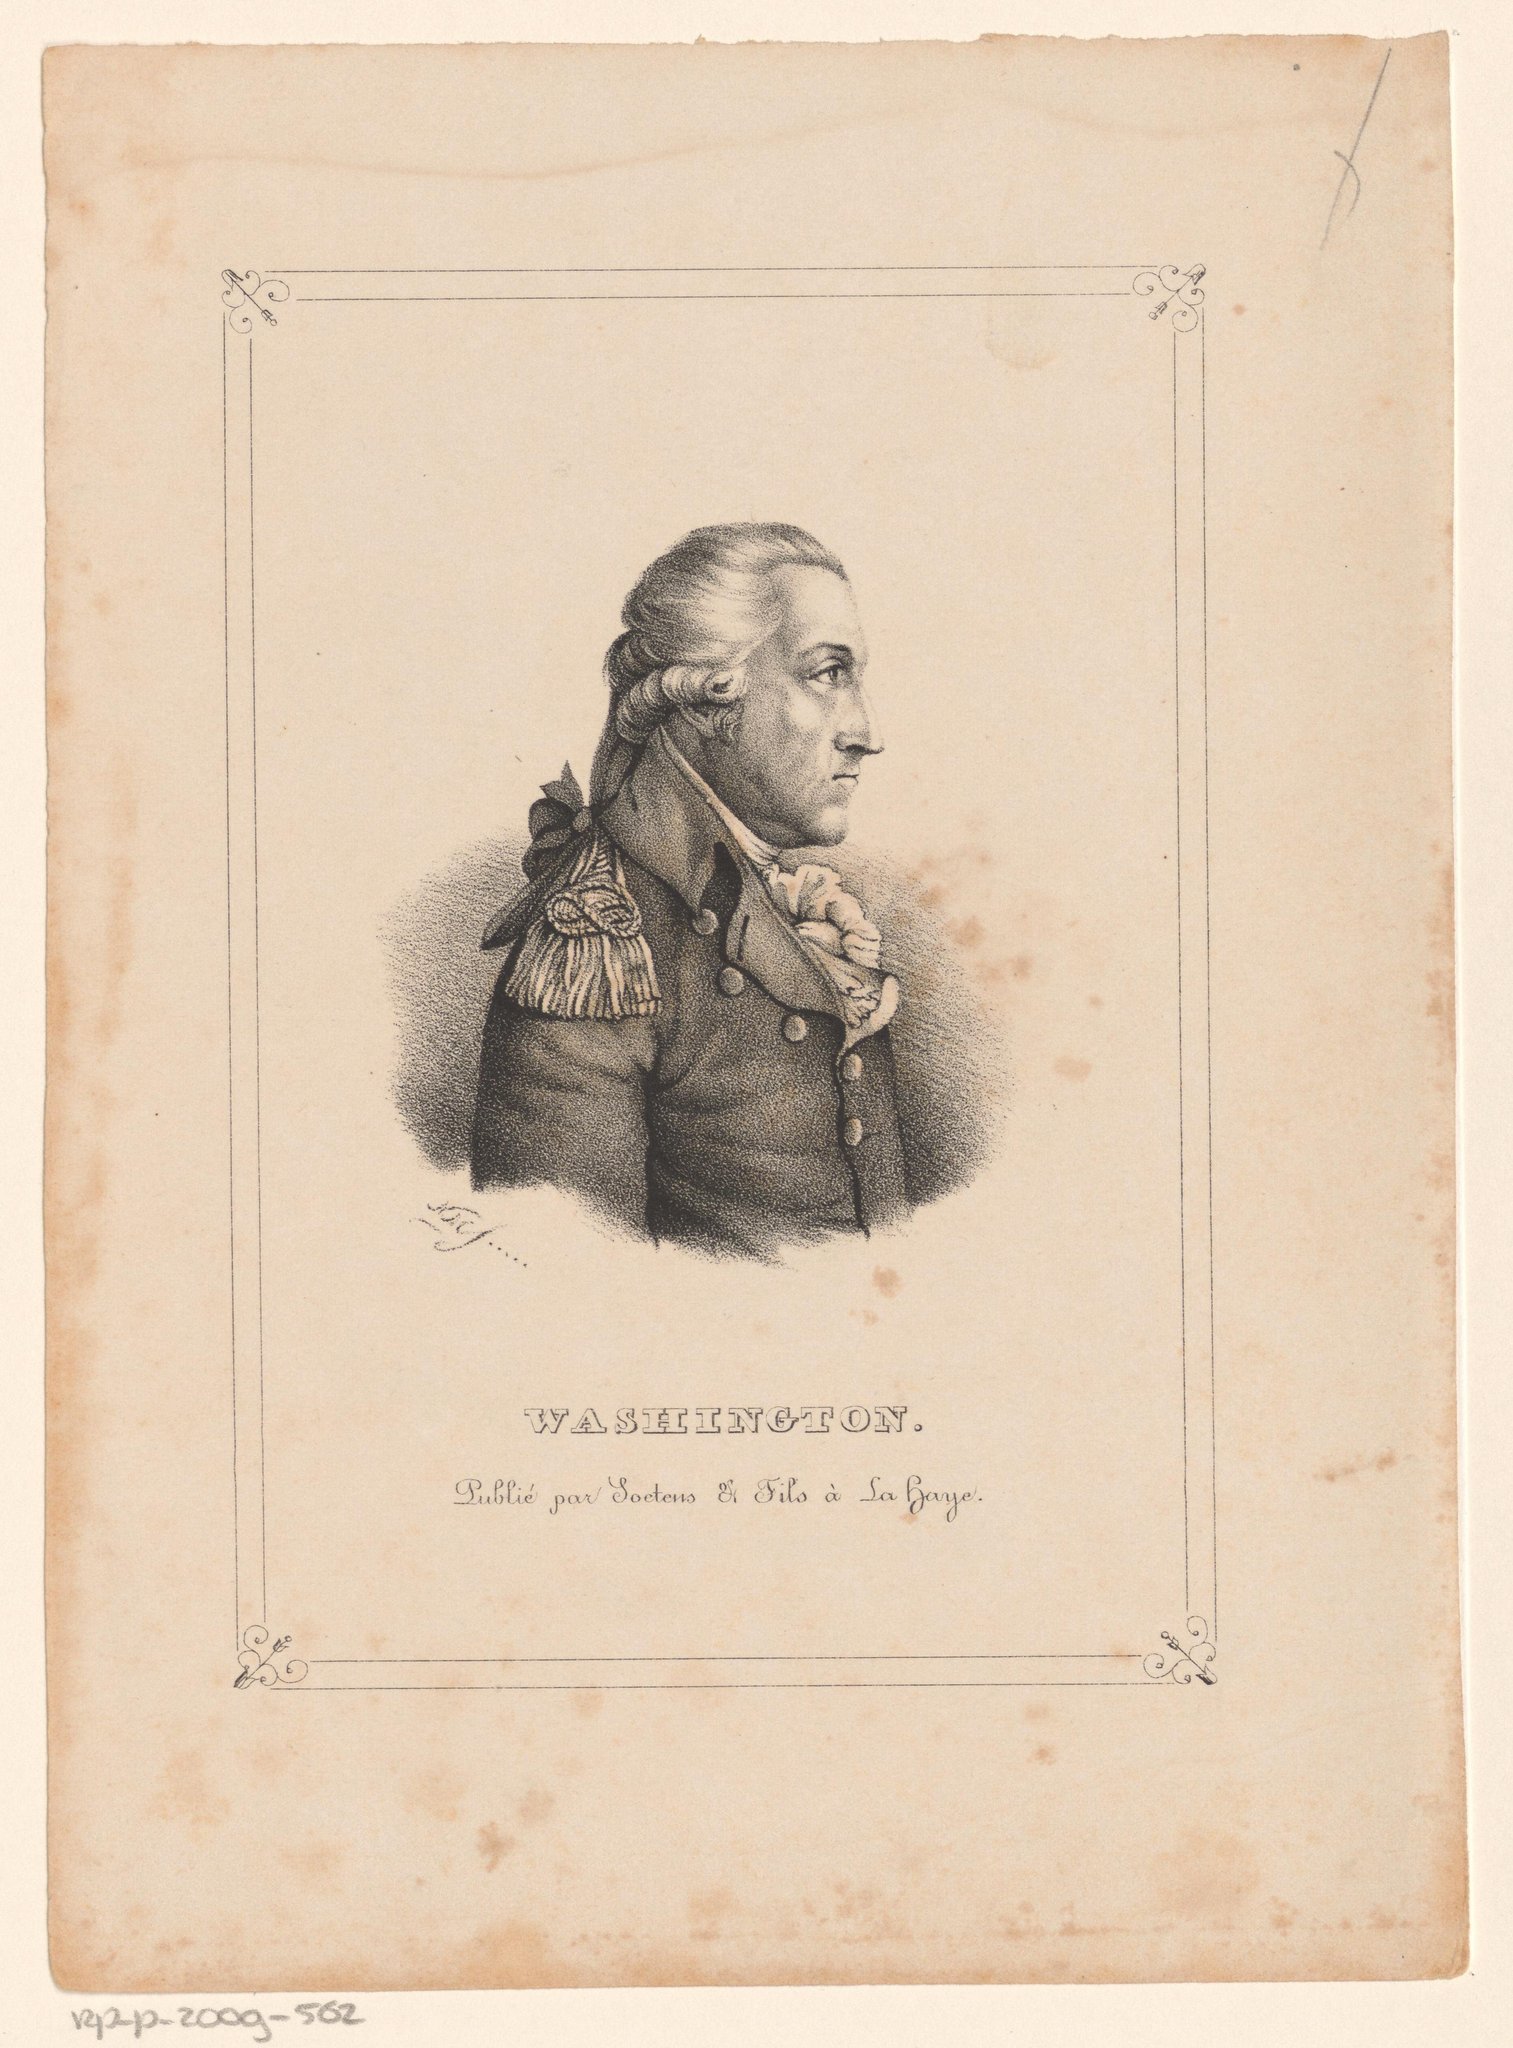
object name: print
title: Portret van George Washington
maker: nicolaas martinus schild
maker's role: draughtsman, print maker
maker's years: 1822-1840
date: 1836-1840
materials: paper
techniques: lithograph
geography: the hague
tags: president ~ head of republic, historical persons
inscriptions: collector's mark: Lugt 2228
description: Portret van George Washington in een omlijsting met in de hoeken decoraties. Geportretteerde is en profil naar rechts in uniform weergegeven. Onder zijn beeltenis staat zijn naam.